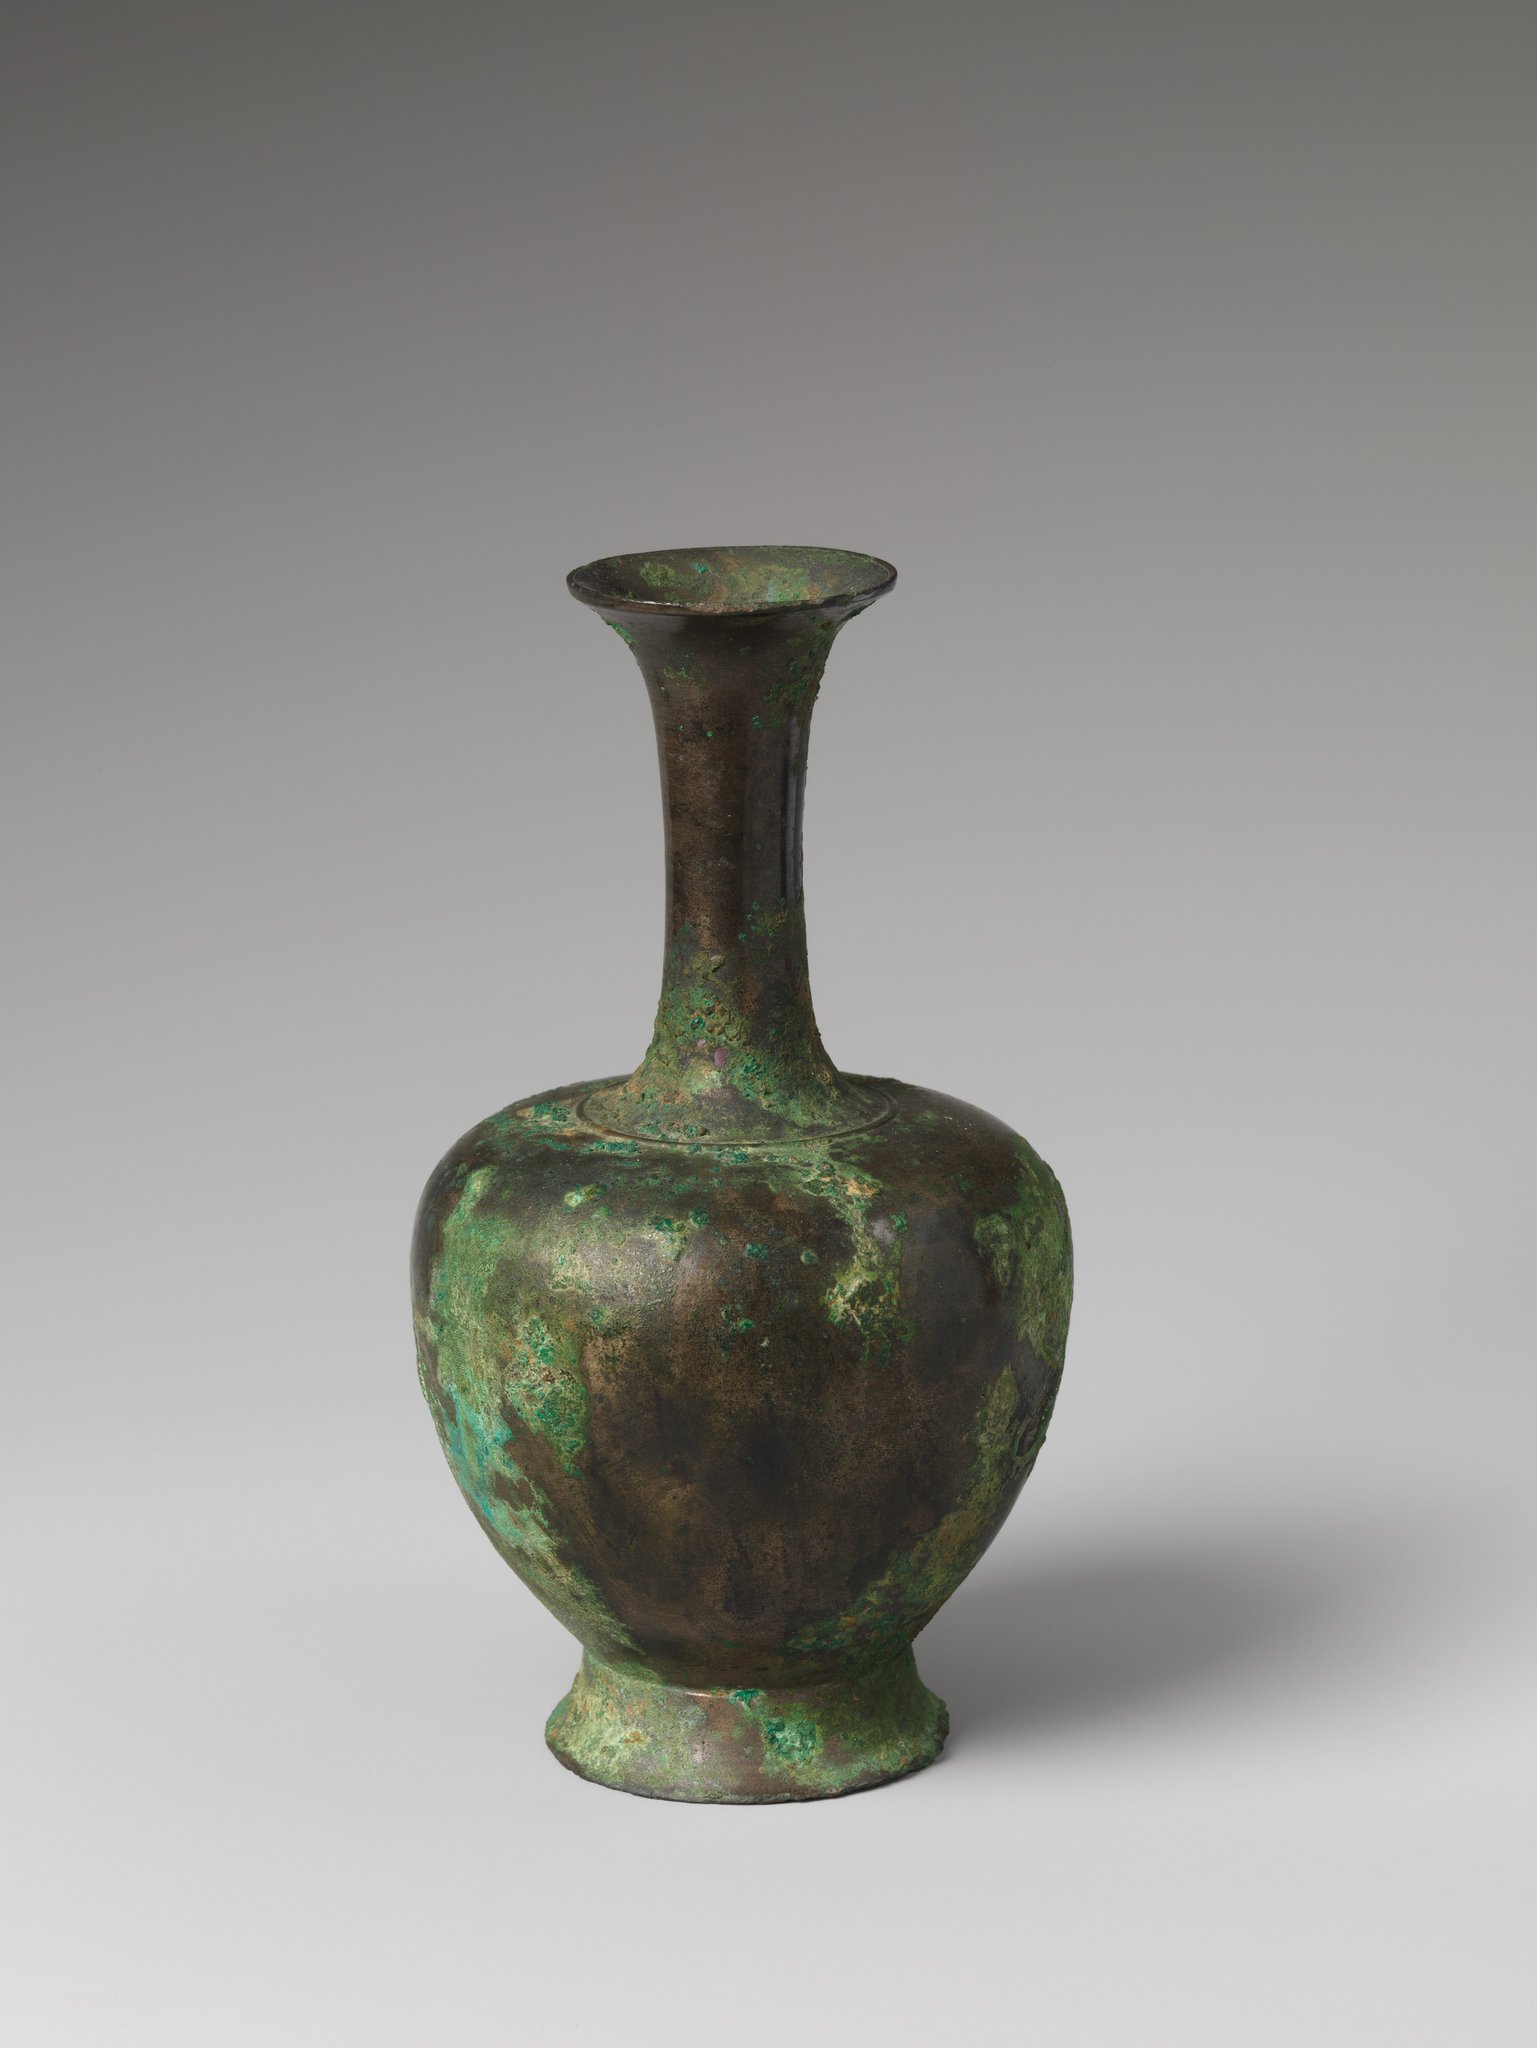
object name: vase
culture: chinese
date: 618-907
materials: bronze